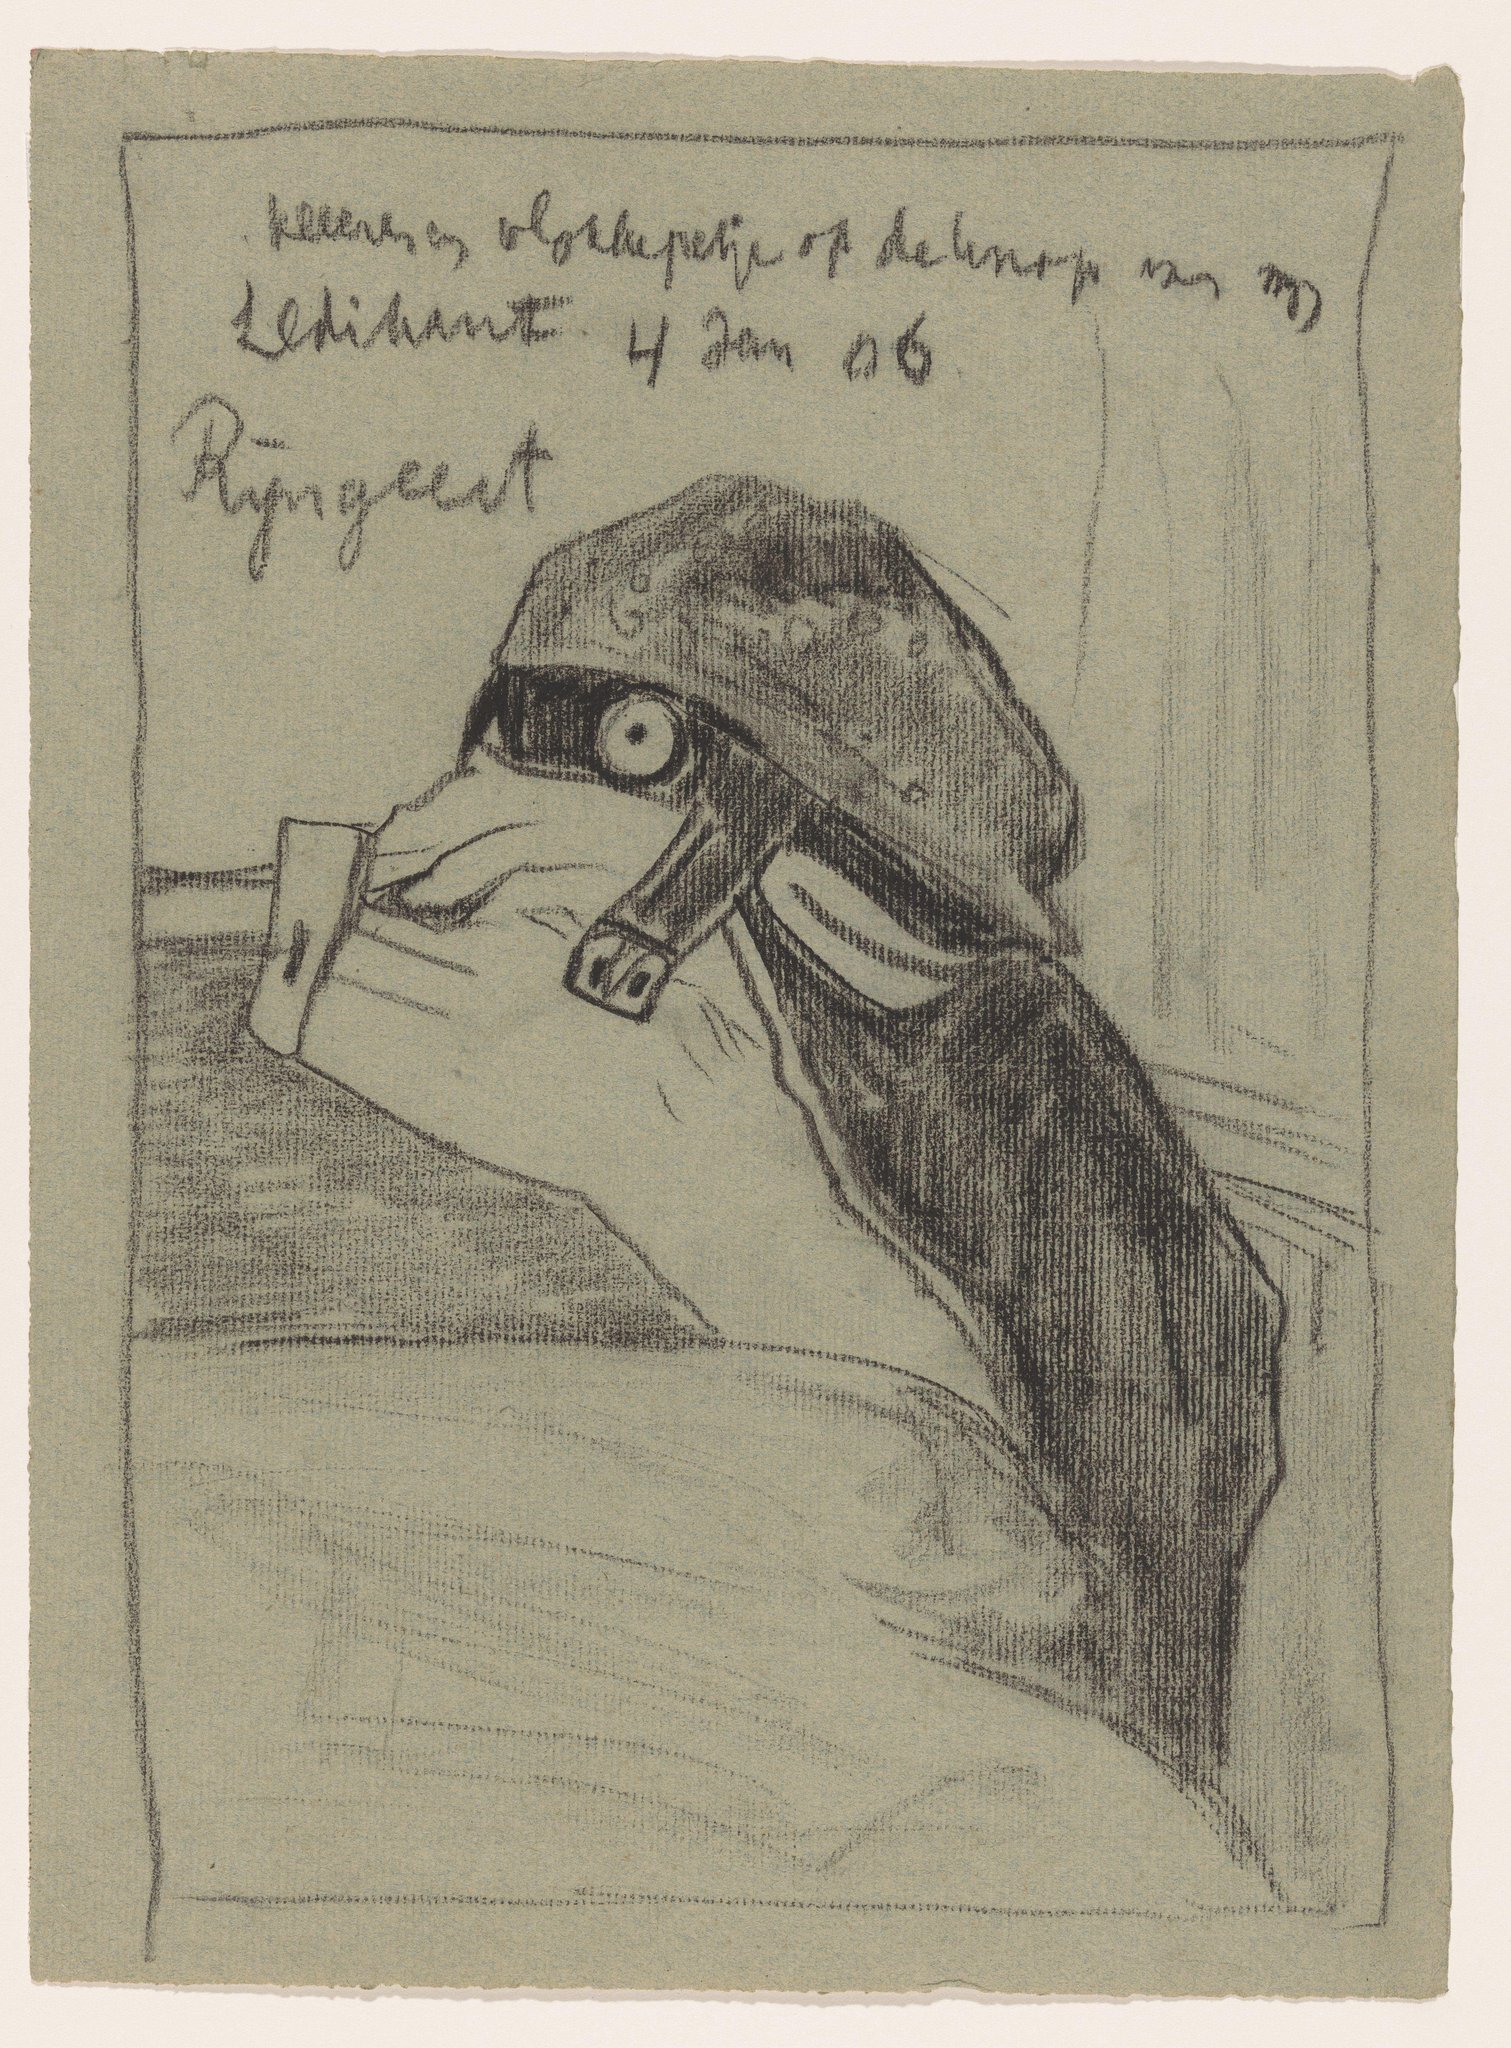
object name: drawing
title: Kleeren en vlokkepetje op de knop van mijn ledikant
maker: theo van hoytema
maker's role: draughtsman, painter, print maker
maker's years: 1863-1917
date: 1906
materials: chalk, paper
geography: oegstgeest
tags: hanging clothes, bed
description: Deze tekening is vervaardigd in de periode dat Hoytema voor enkele maanden was opgenomen in het sanatorium Rhijngeest.